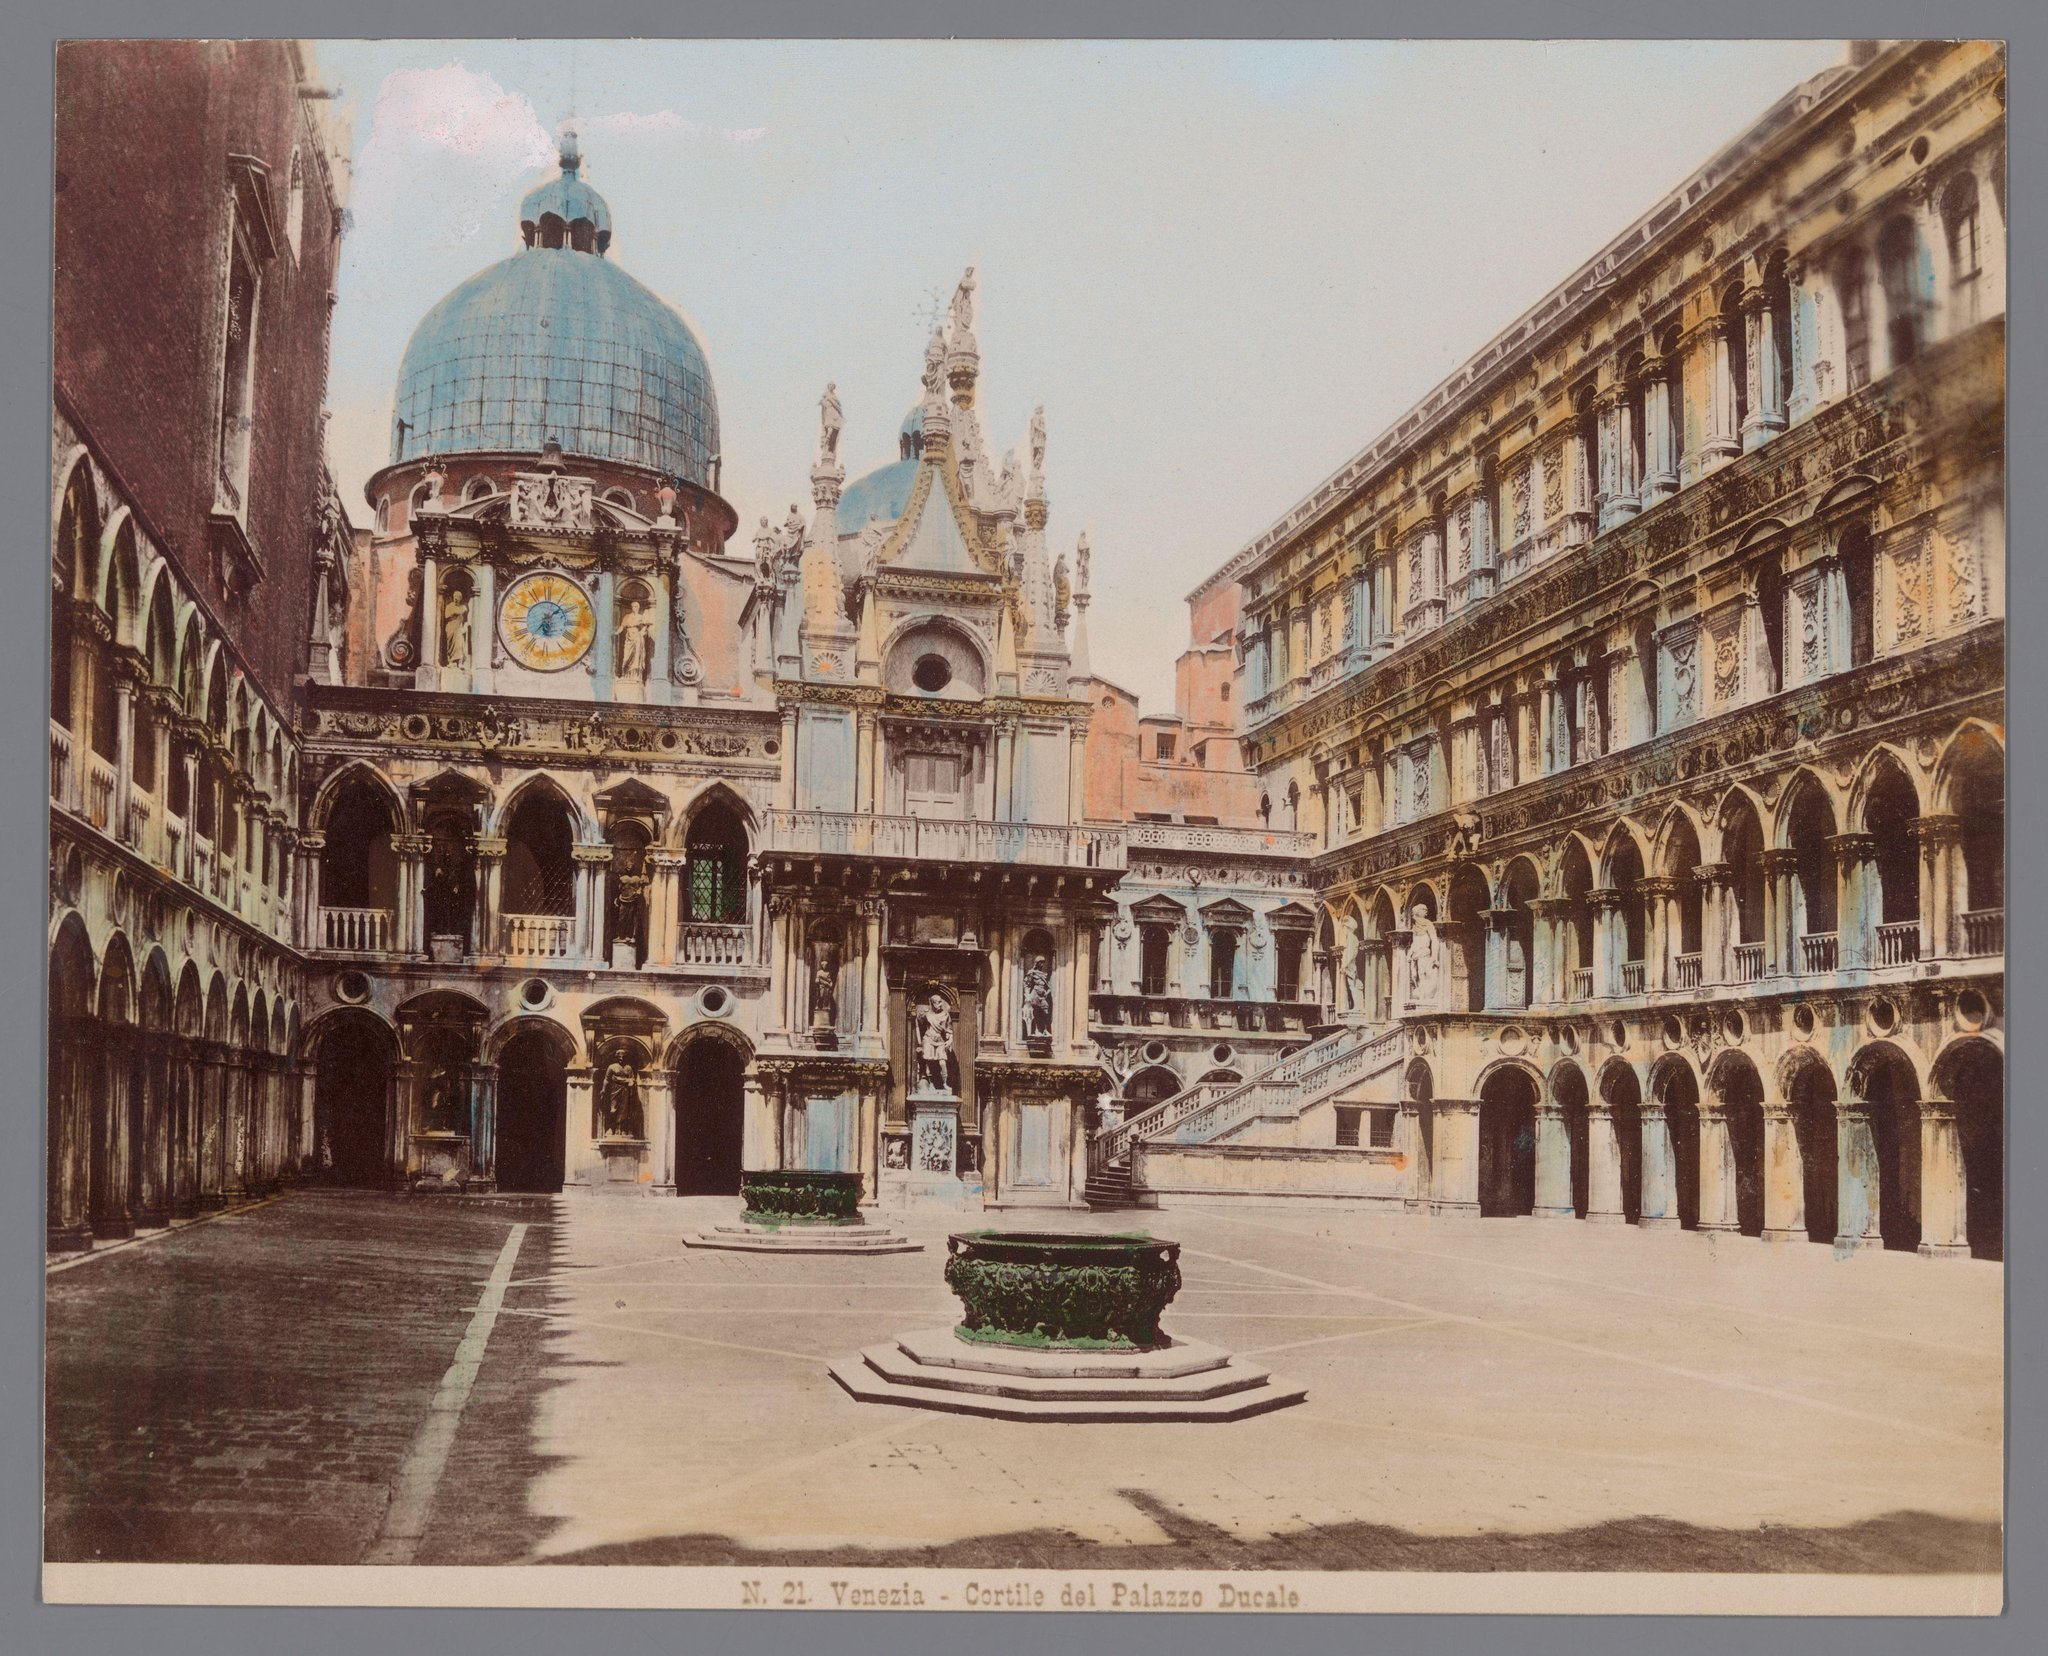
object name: photograph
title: Cortile van het Dogepaleis te Venetië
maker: Anonymous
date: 1851-1900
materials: paper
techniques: albumen print, hand coloring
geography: venice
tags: ornamental fountain, inner court of palace or 'hôtel'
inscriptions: number: ‘N. 21.’